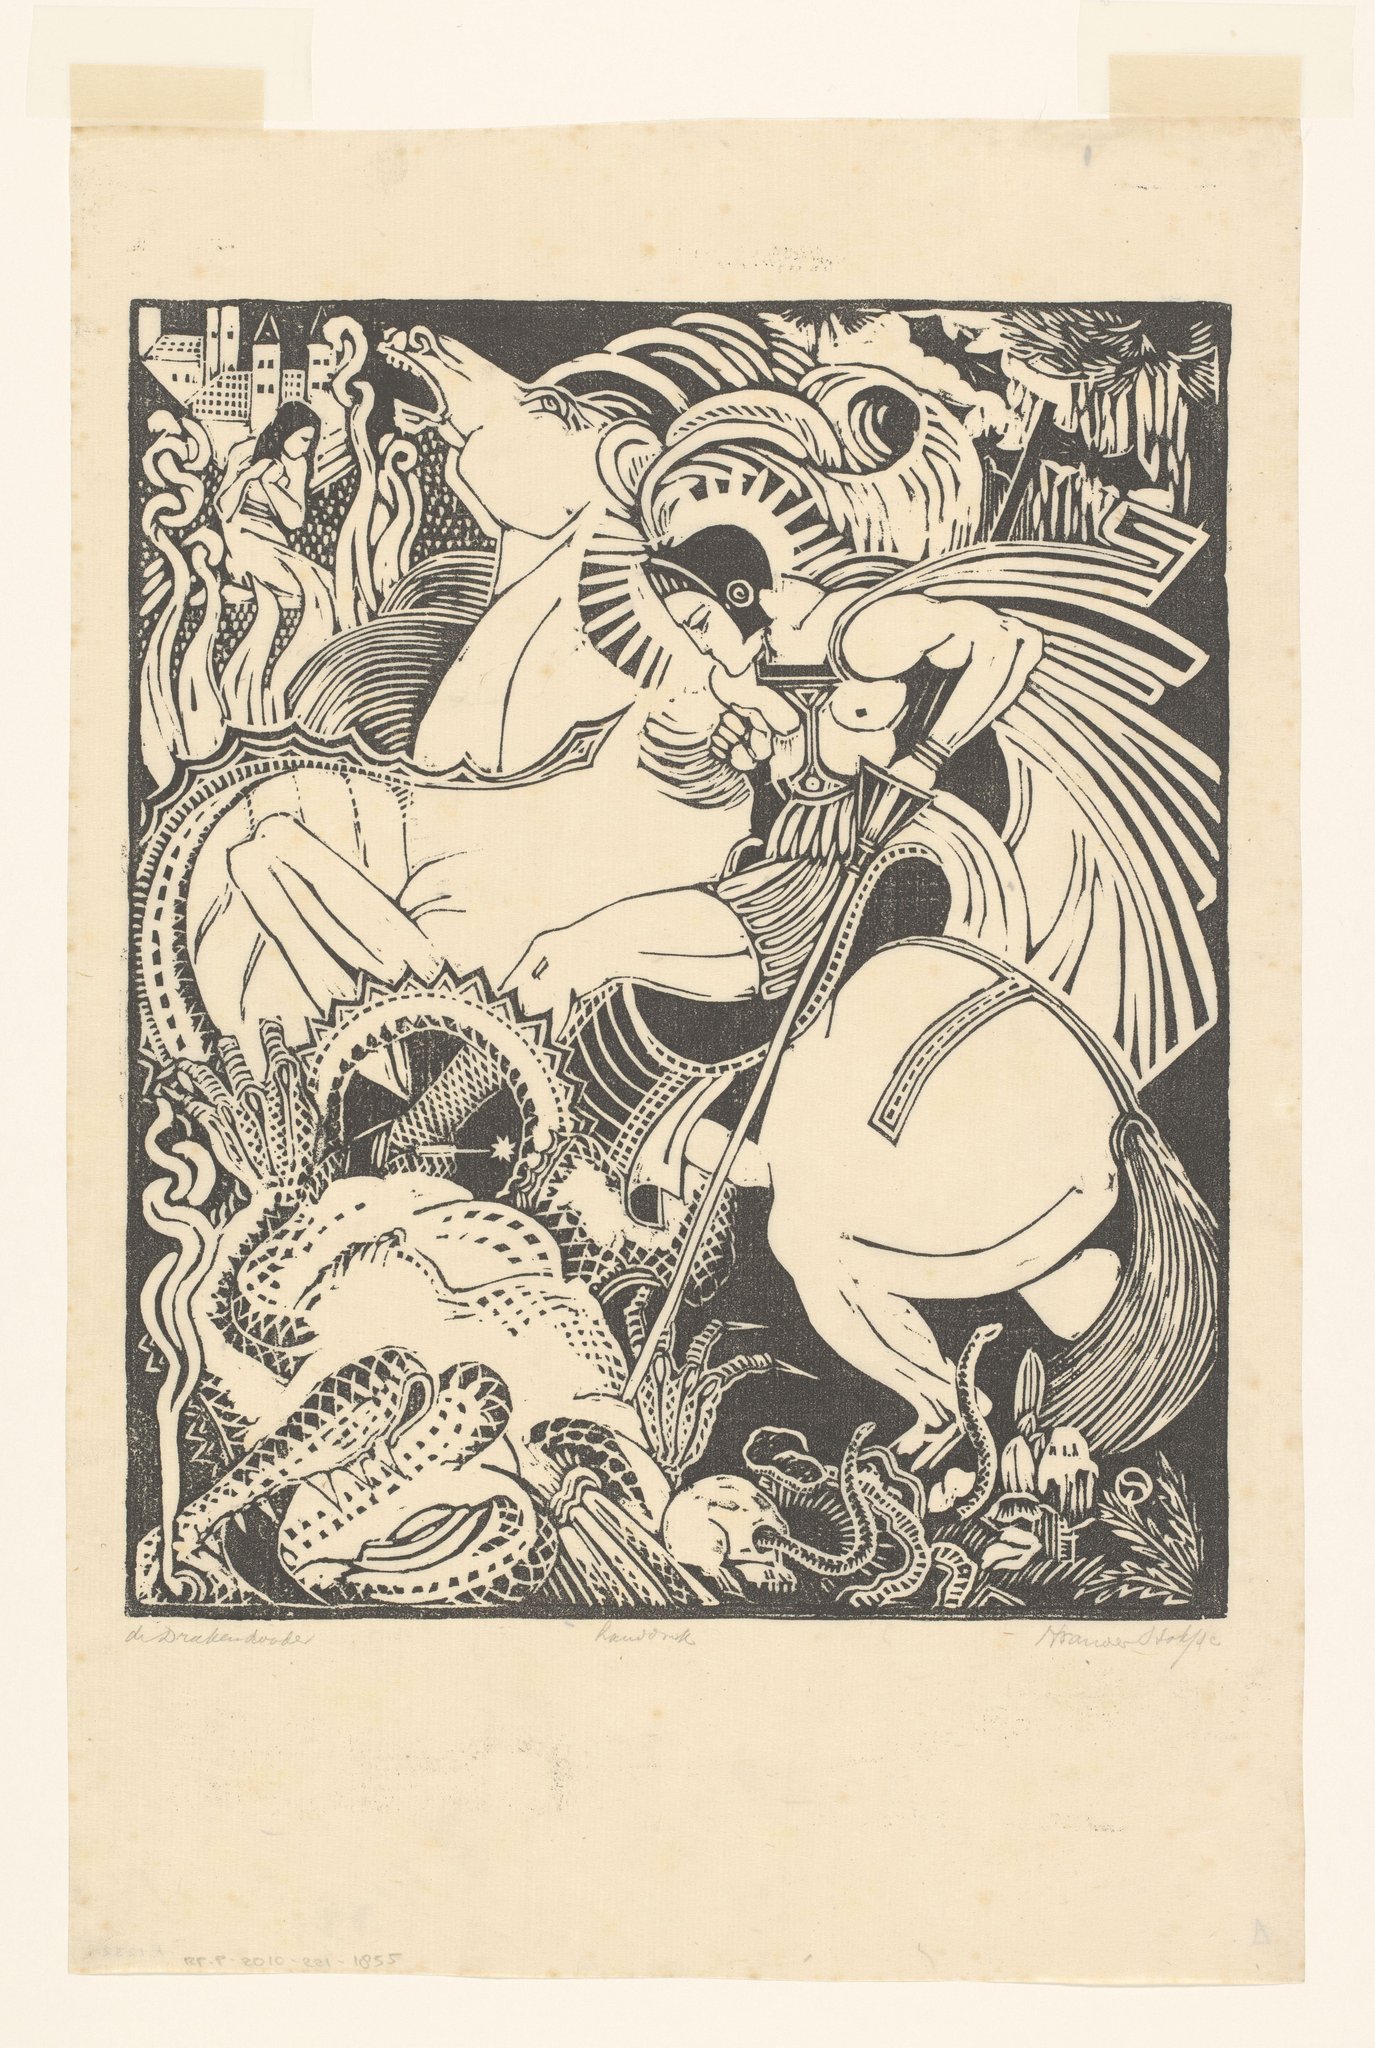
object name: print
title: De Drakendooder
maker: henri van der stok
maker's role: print maker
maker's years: 1870-1946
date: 1900-1946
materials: paper, ink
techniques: linocut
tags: perseus frees andromeda of her chains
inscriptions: signature: ‘HvanderStok’, title: ‘De Drakendooder’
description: Man met zwaard op een paard boven een draakachtig wezen, op de achtergrond een vrouwelijk naakt bij een kasteel.